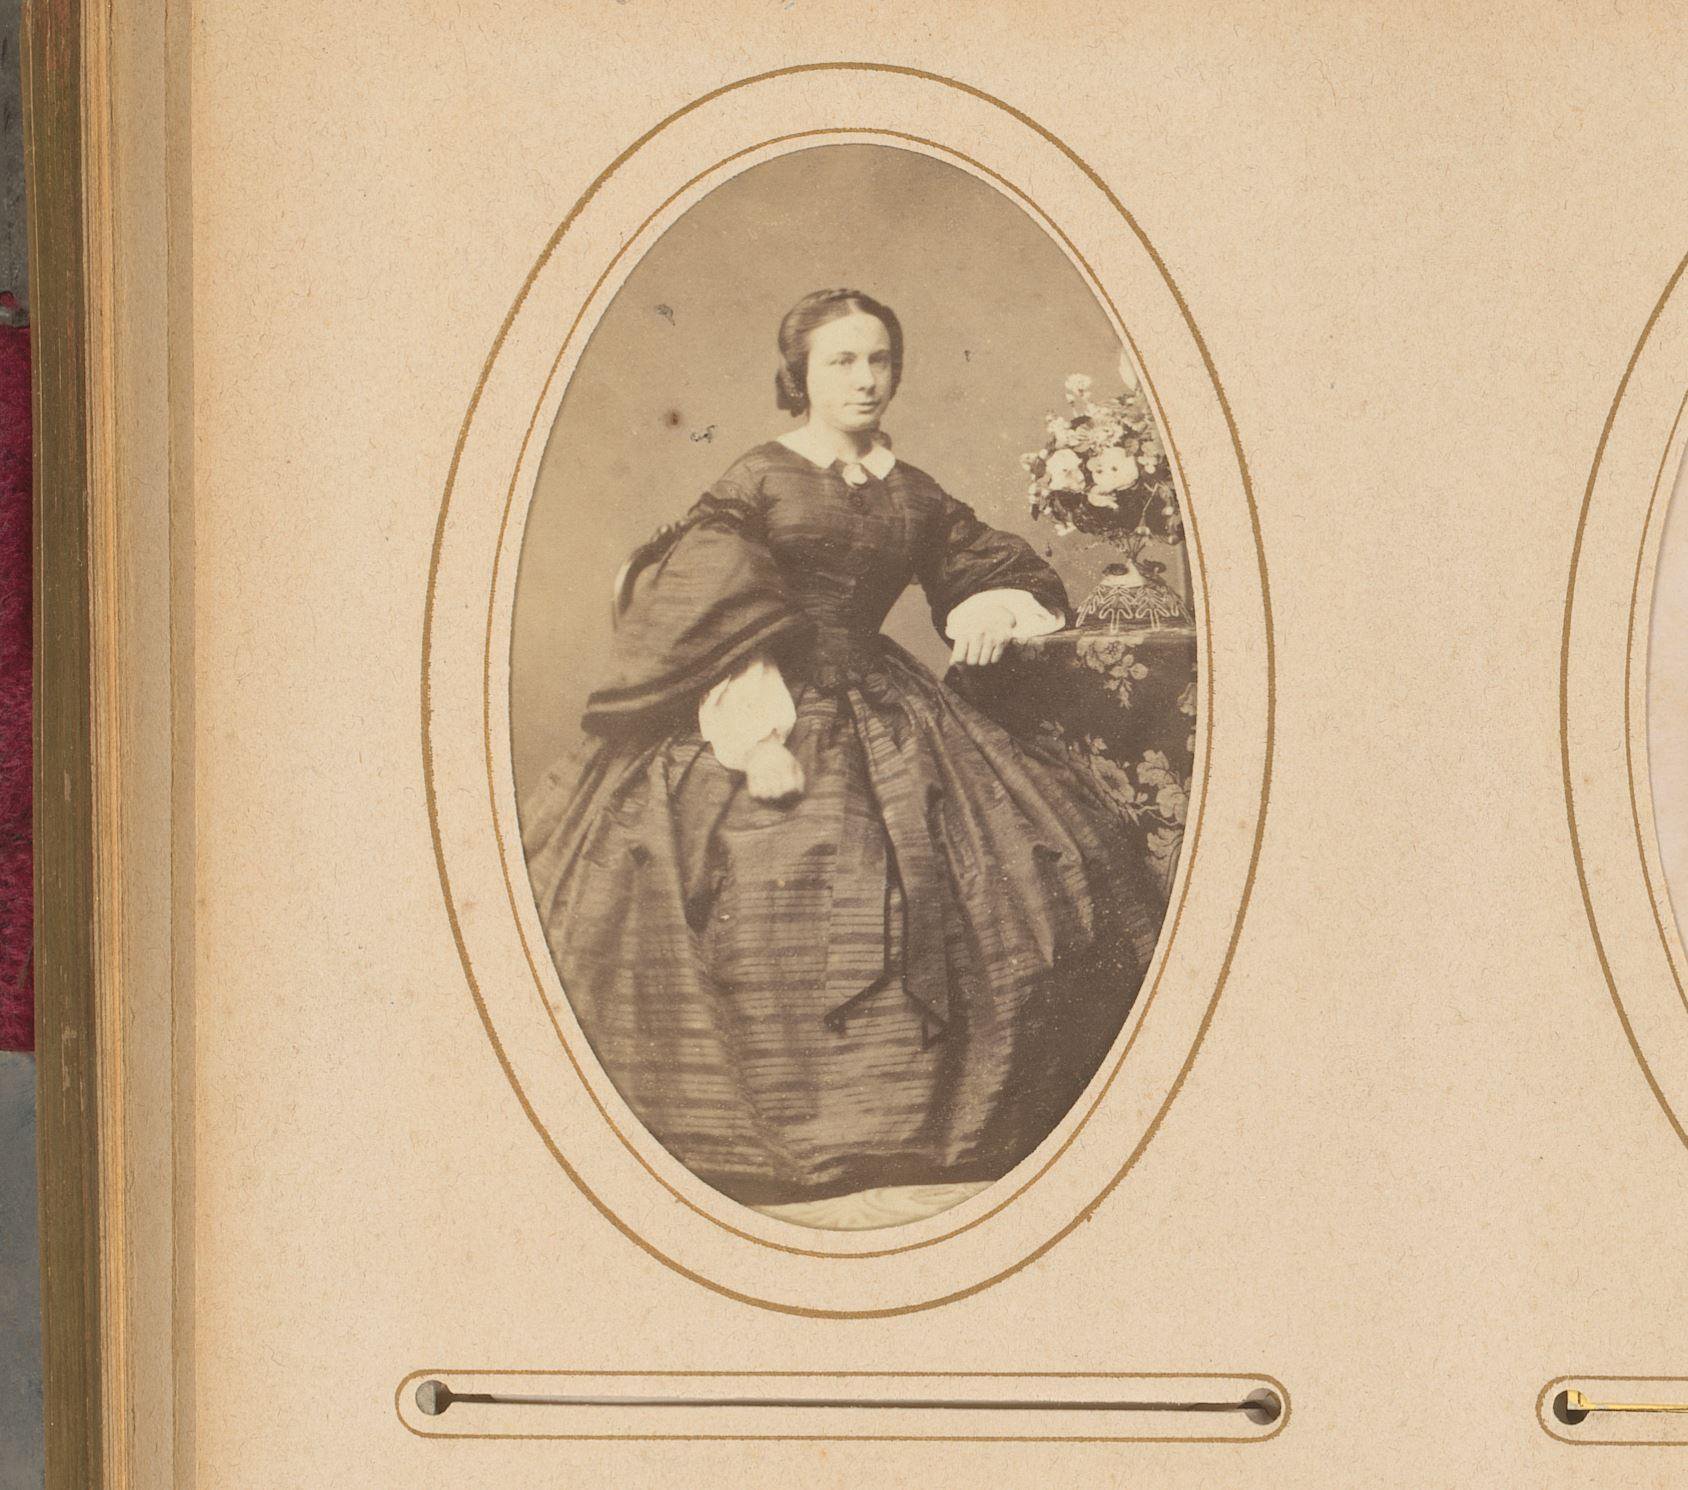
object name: photograph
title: Portret van een zittende vrouw zittend bij een tafel met bloemstuk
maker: maria hille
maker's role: fotograaf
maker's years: 1827-1893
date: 1859-1867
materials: cardboard, photographic support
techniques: albumen print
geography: the hague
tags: cut flowers; nosegay, bunch of flowers, historical persons - bb - woman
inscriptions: inscription: ‘M. Hille Photograaf/ Willemstraat 12/ 's Gravenhage’